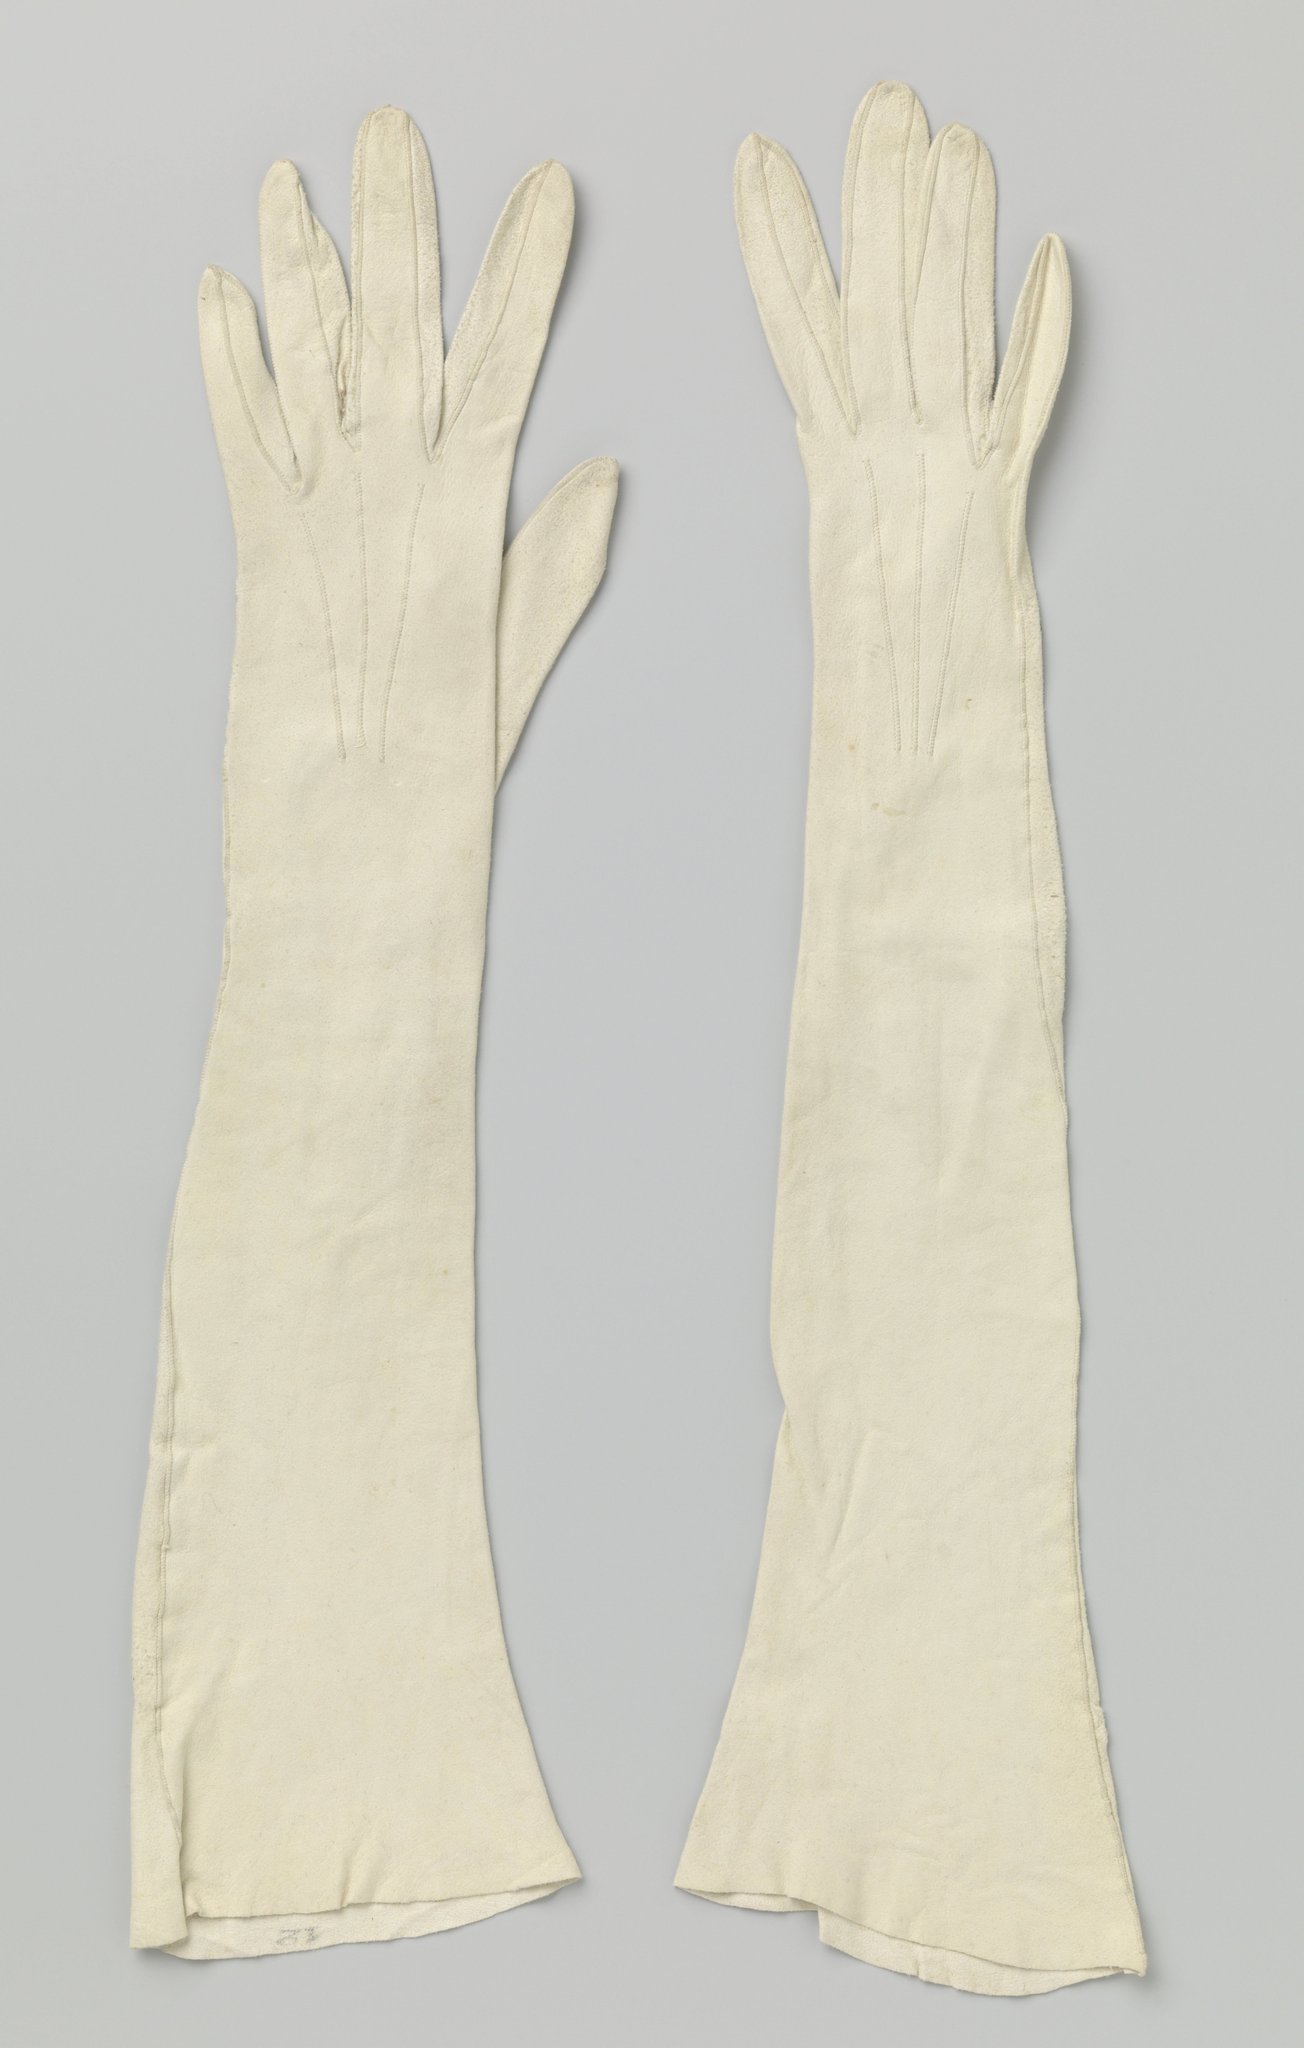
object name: glove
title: Handschoen van wit zeemleer met knoopsluiting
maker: Anonymous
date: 1900-1925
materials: leather, mother of pearl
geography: france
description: Rechterhandschoen van zeemleer. Bij de pols een split, afgezet met wit leer en drie parelmoeren platte knopen. Adres (grotendeels weggewassen): Grand Prix Paris 1900.